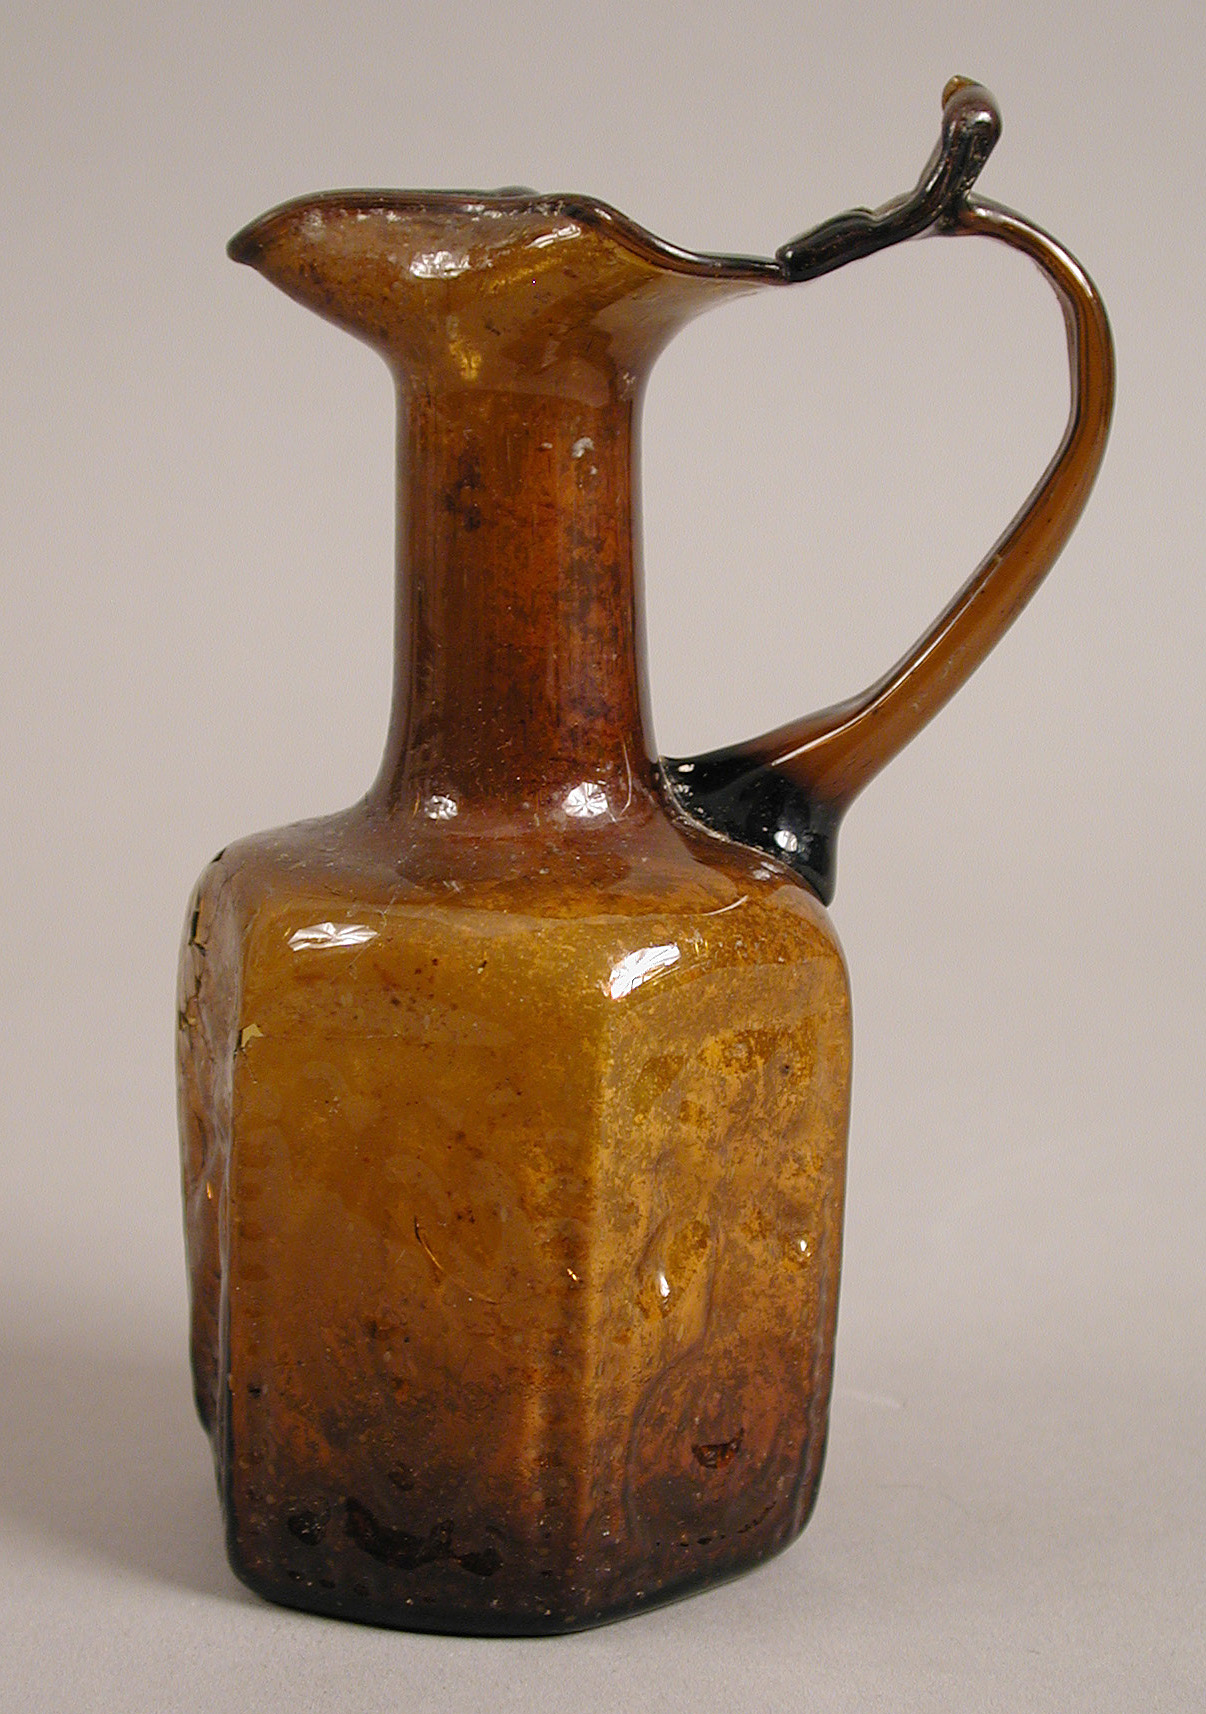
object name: jug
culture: byzantine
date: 501-700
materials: glass